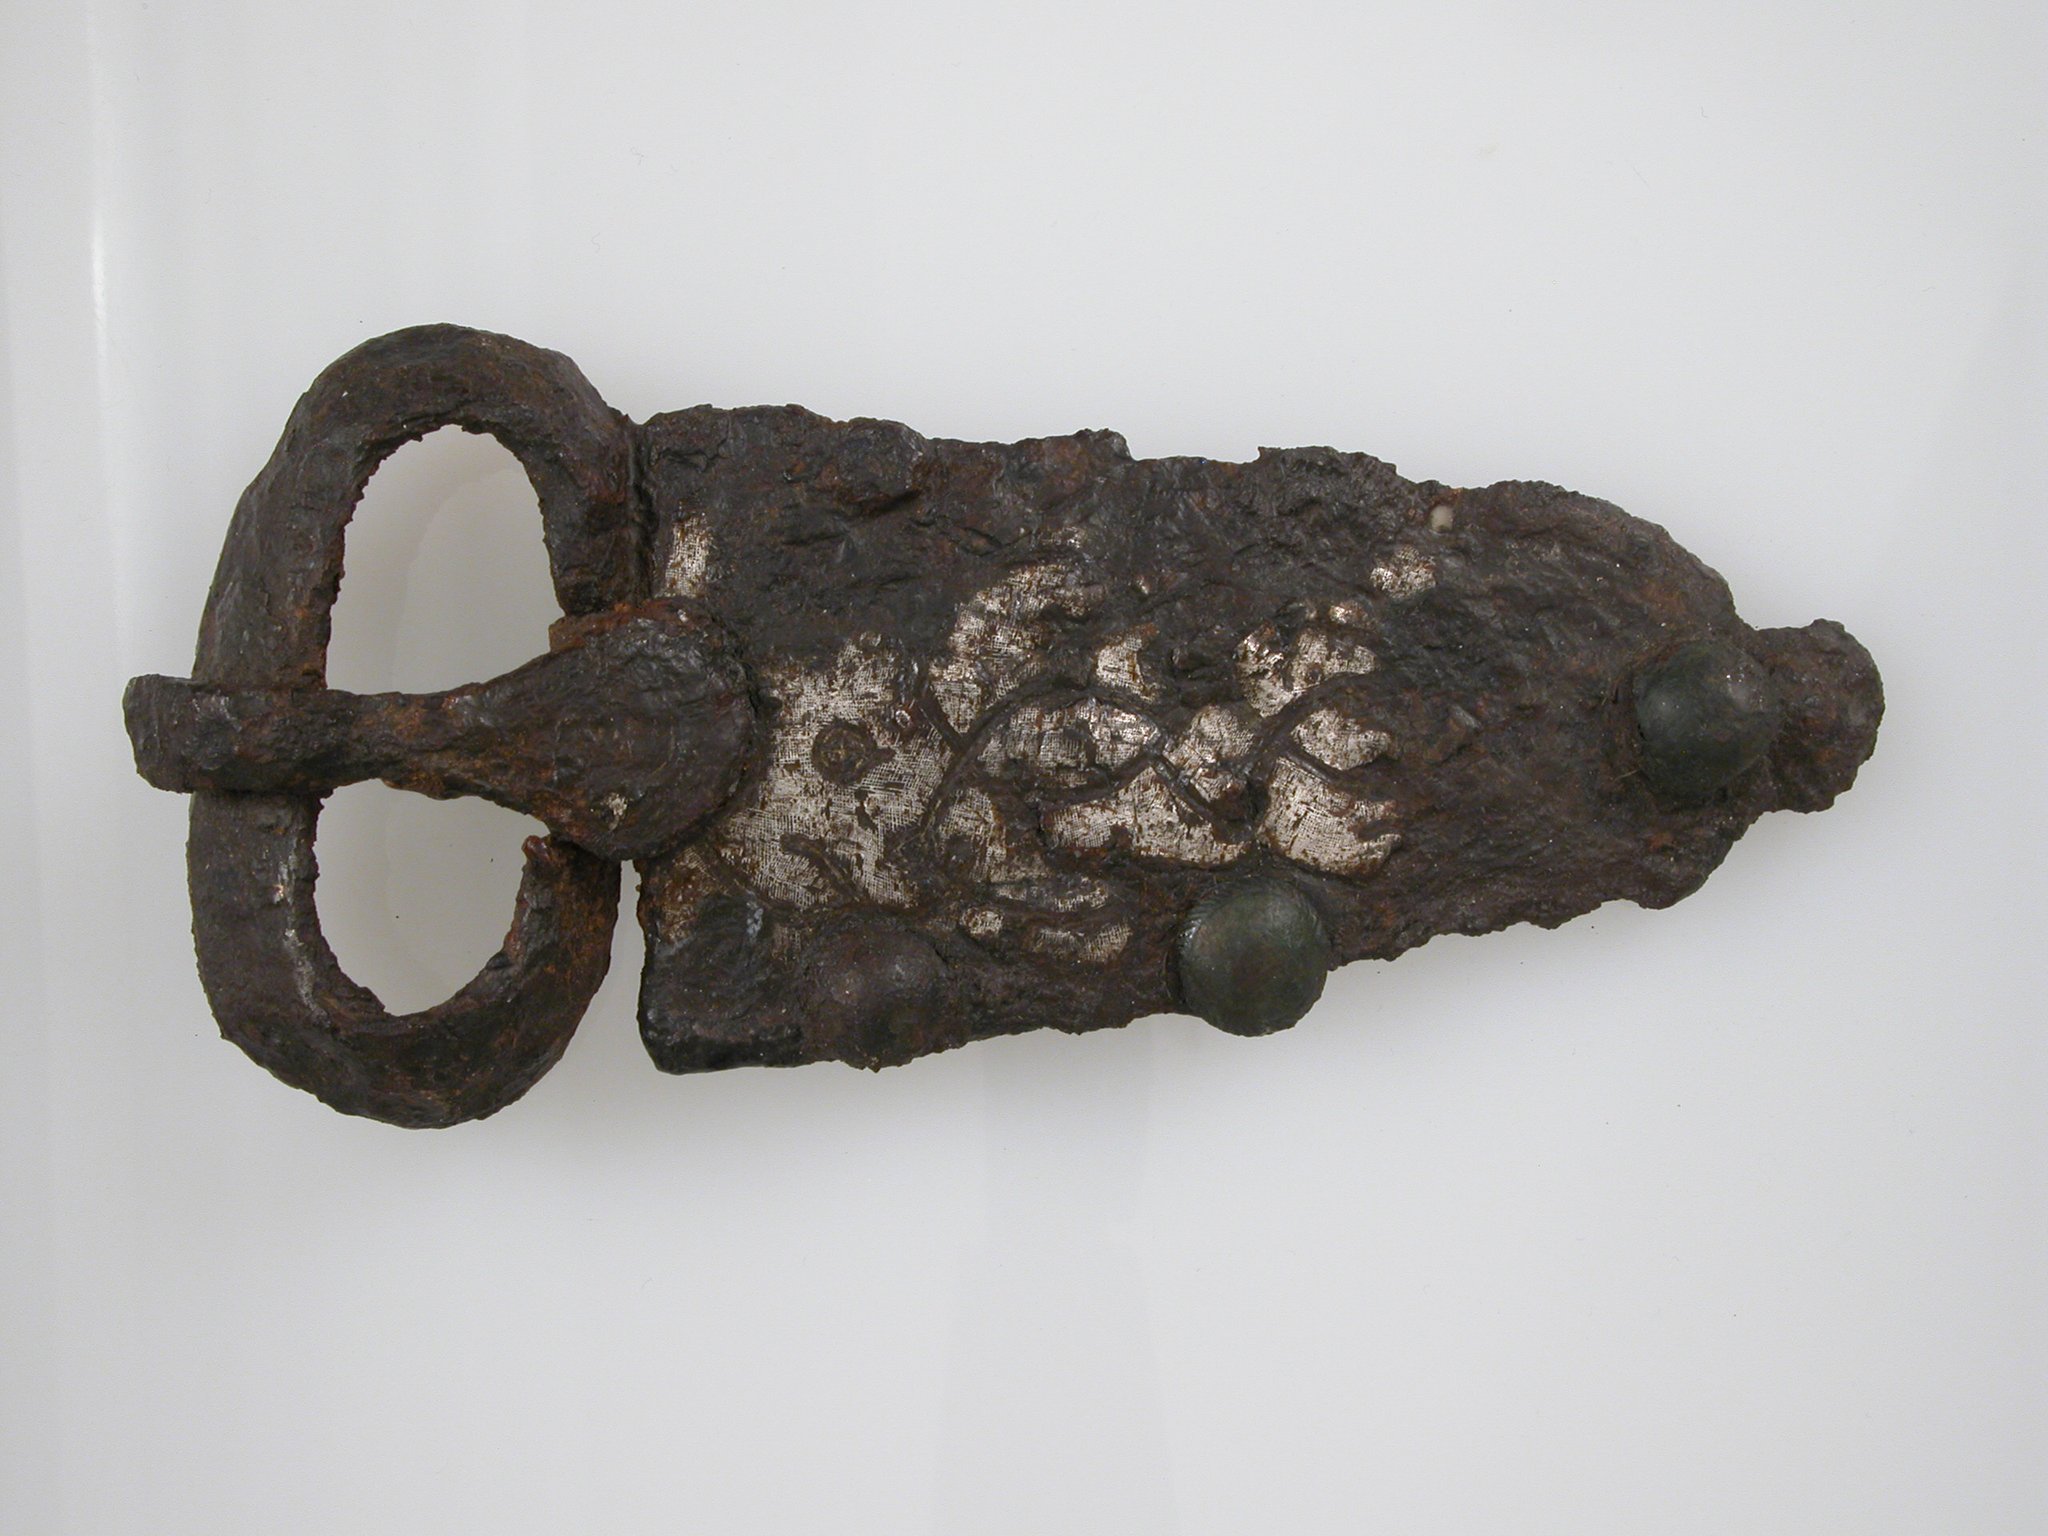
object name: belt buckle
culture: burgundian or frankish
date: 501-700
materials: bronze, iron, silver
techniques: inlay